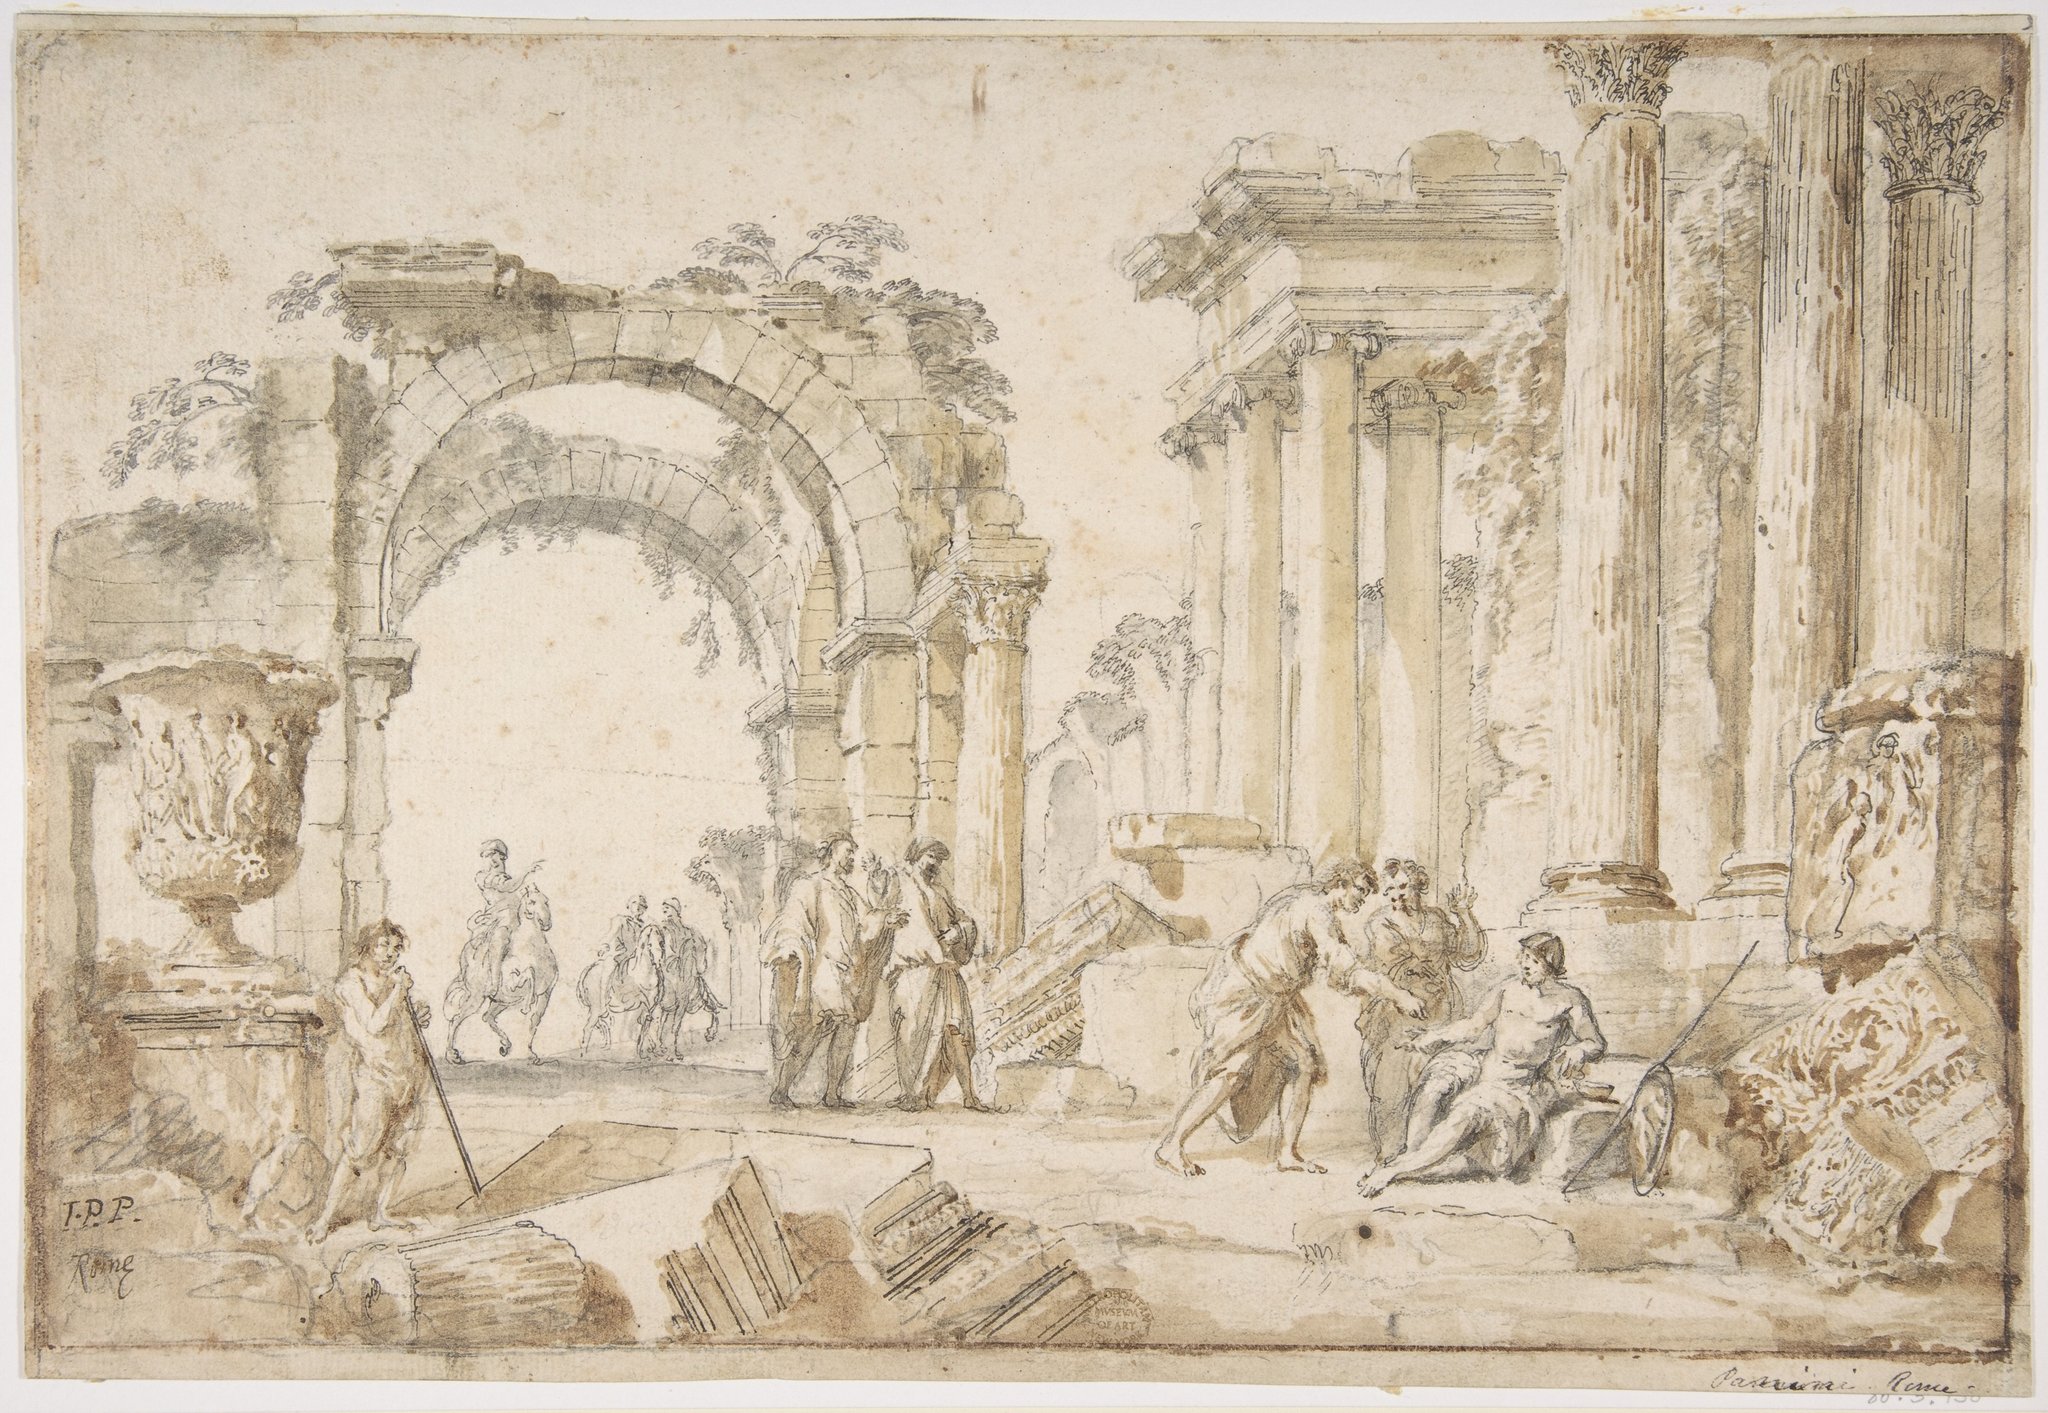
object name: drawing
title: Figures in Classical Ruins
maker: giovanni paolo panini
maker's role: artist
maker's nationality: italian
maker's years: 1691-1765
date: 1691-1765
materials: chalk, ink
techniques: brush, pen, wash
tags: human figures,arches,columns,ruins